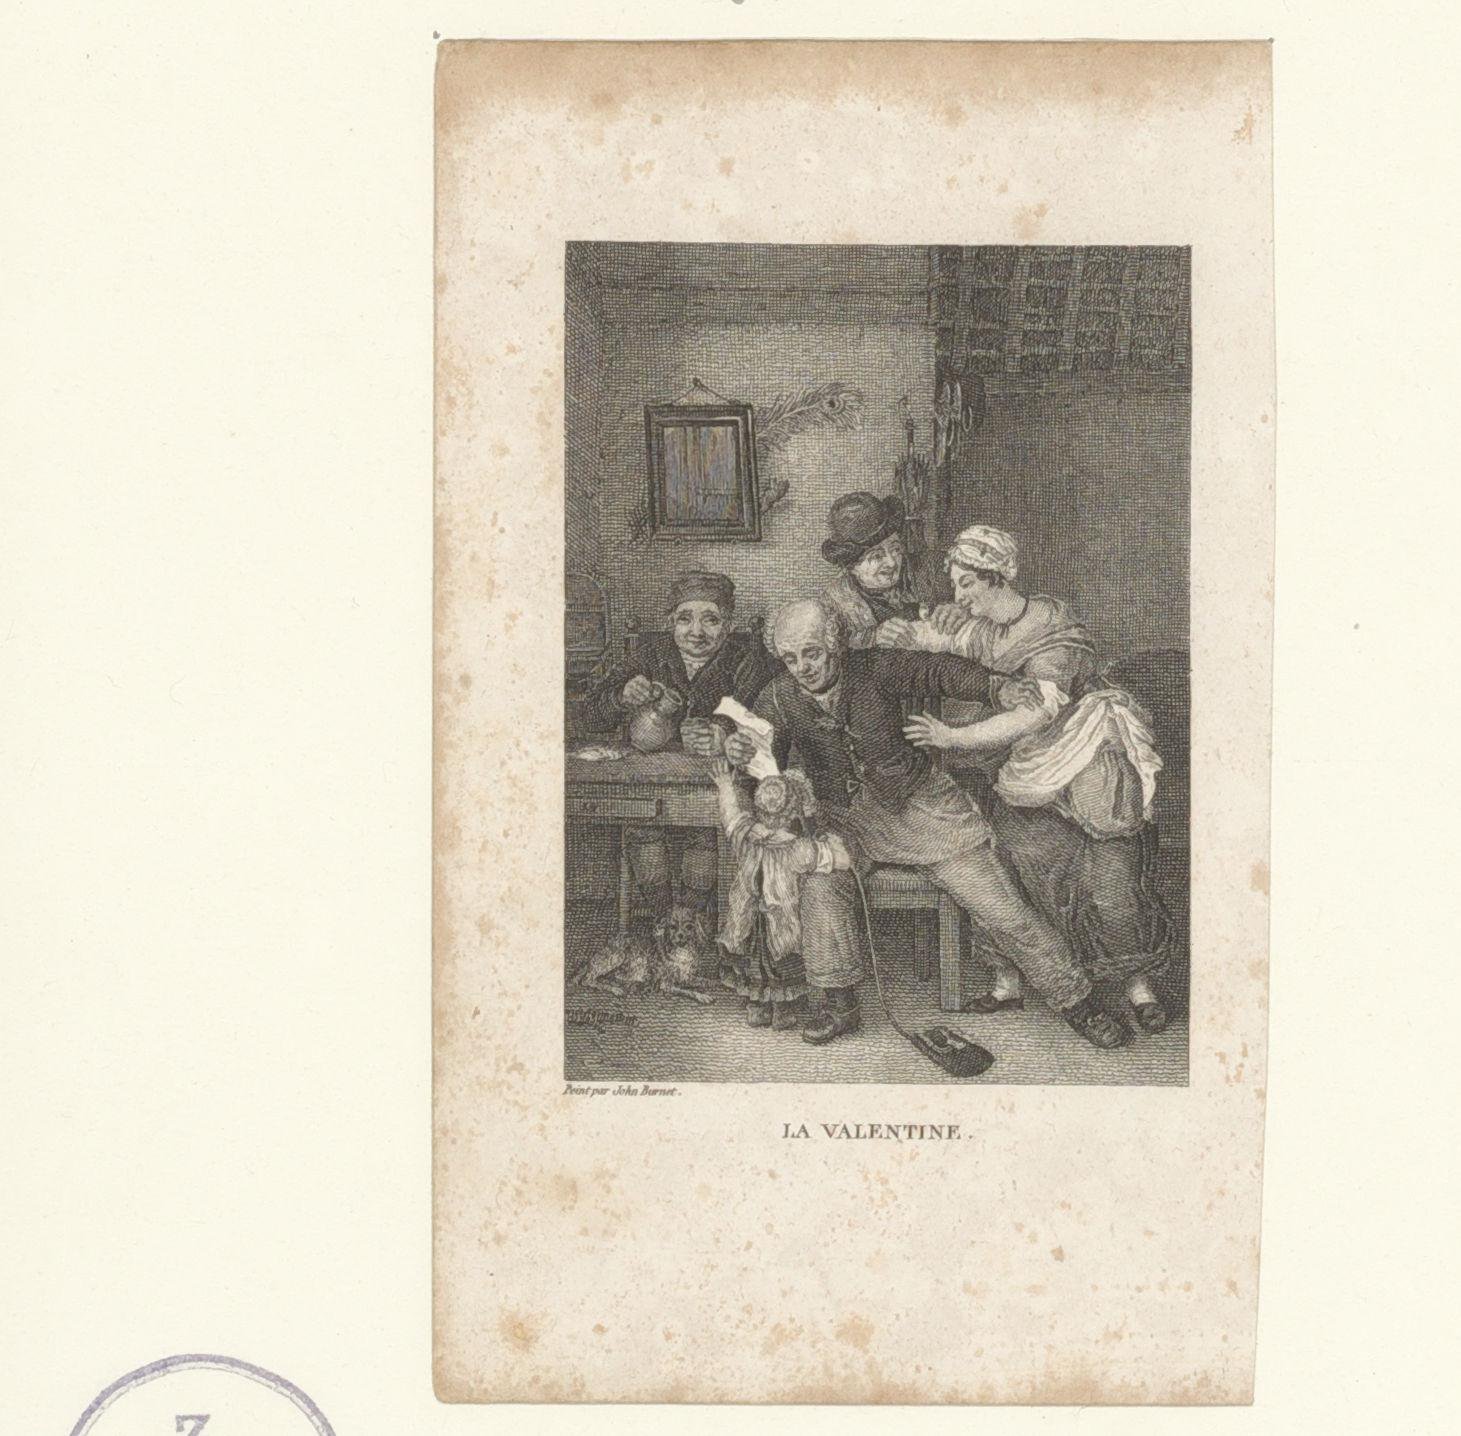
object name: print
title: Man leest een Valentijnskaart van een vrouw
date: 1800-1899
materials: paper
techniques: etching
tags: reading, writing and letters, family relationships (first, second, third and fourth degree), generations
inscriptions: stamp, collector's mark: Lugt 1641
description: Onderwerpsrubrieken binnen de Atlas Zeden en Gewoonten: Zeden en Gewoonten in Engeren Zin, Des menschen beging, midden en einde, Kinderleven – Kinderspel en Kinderprenten.